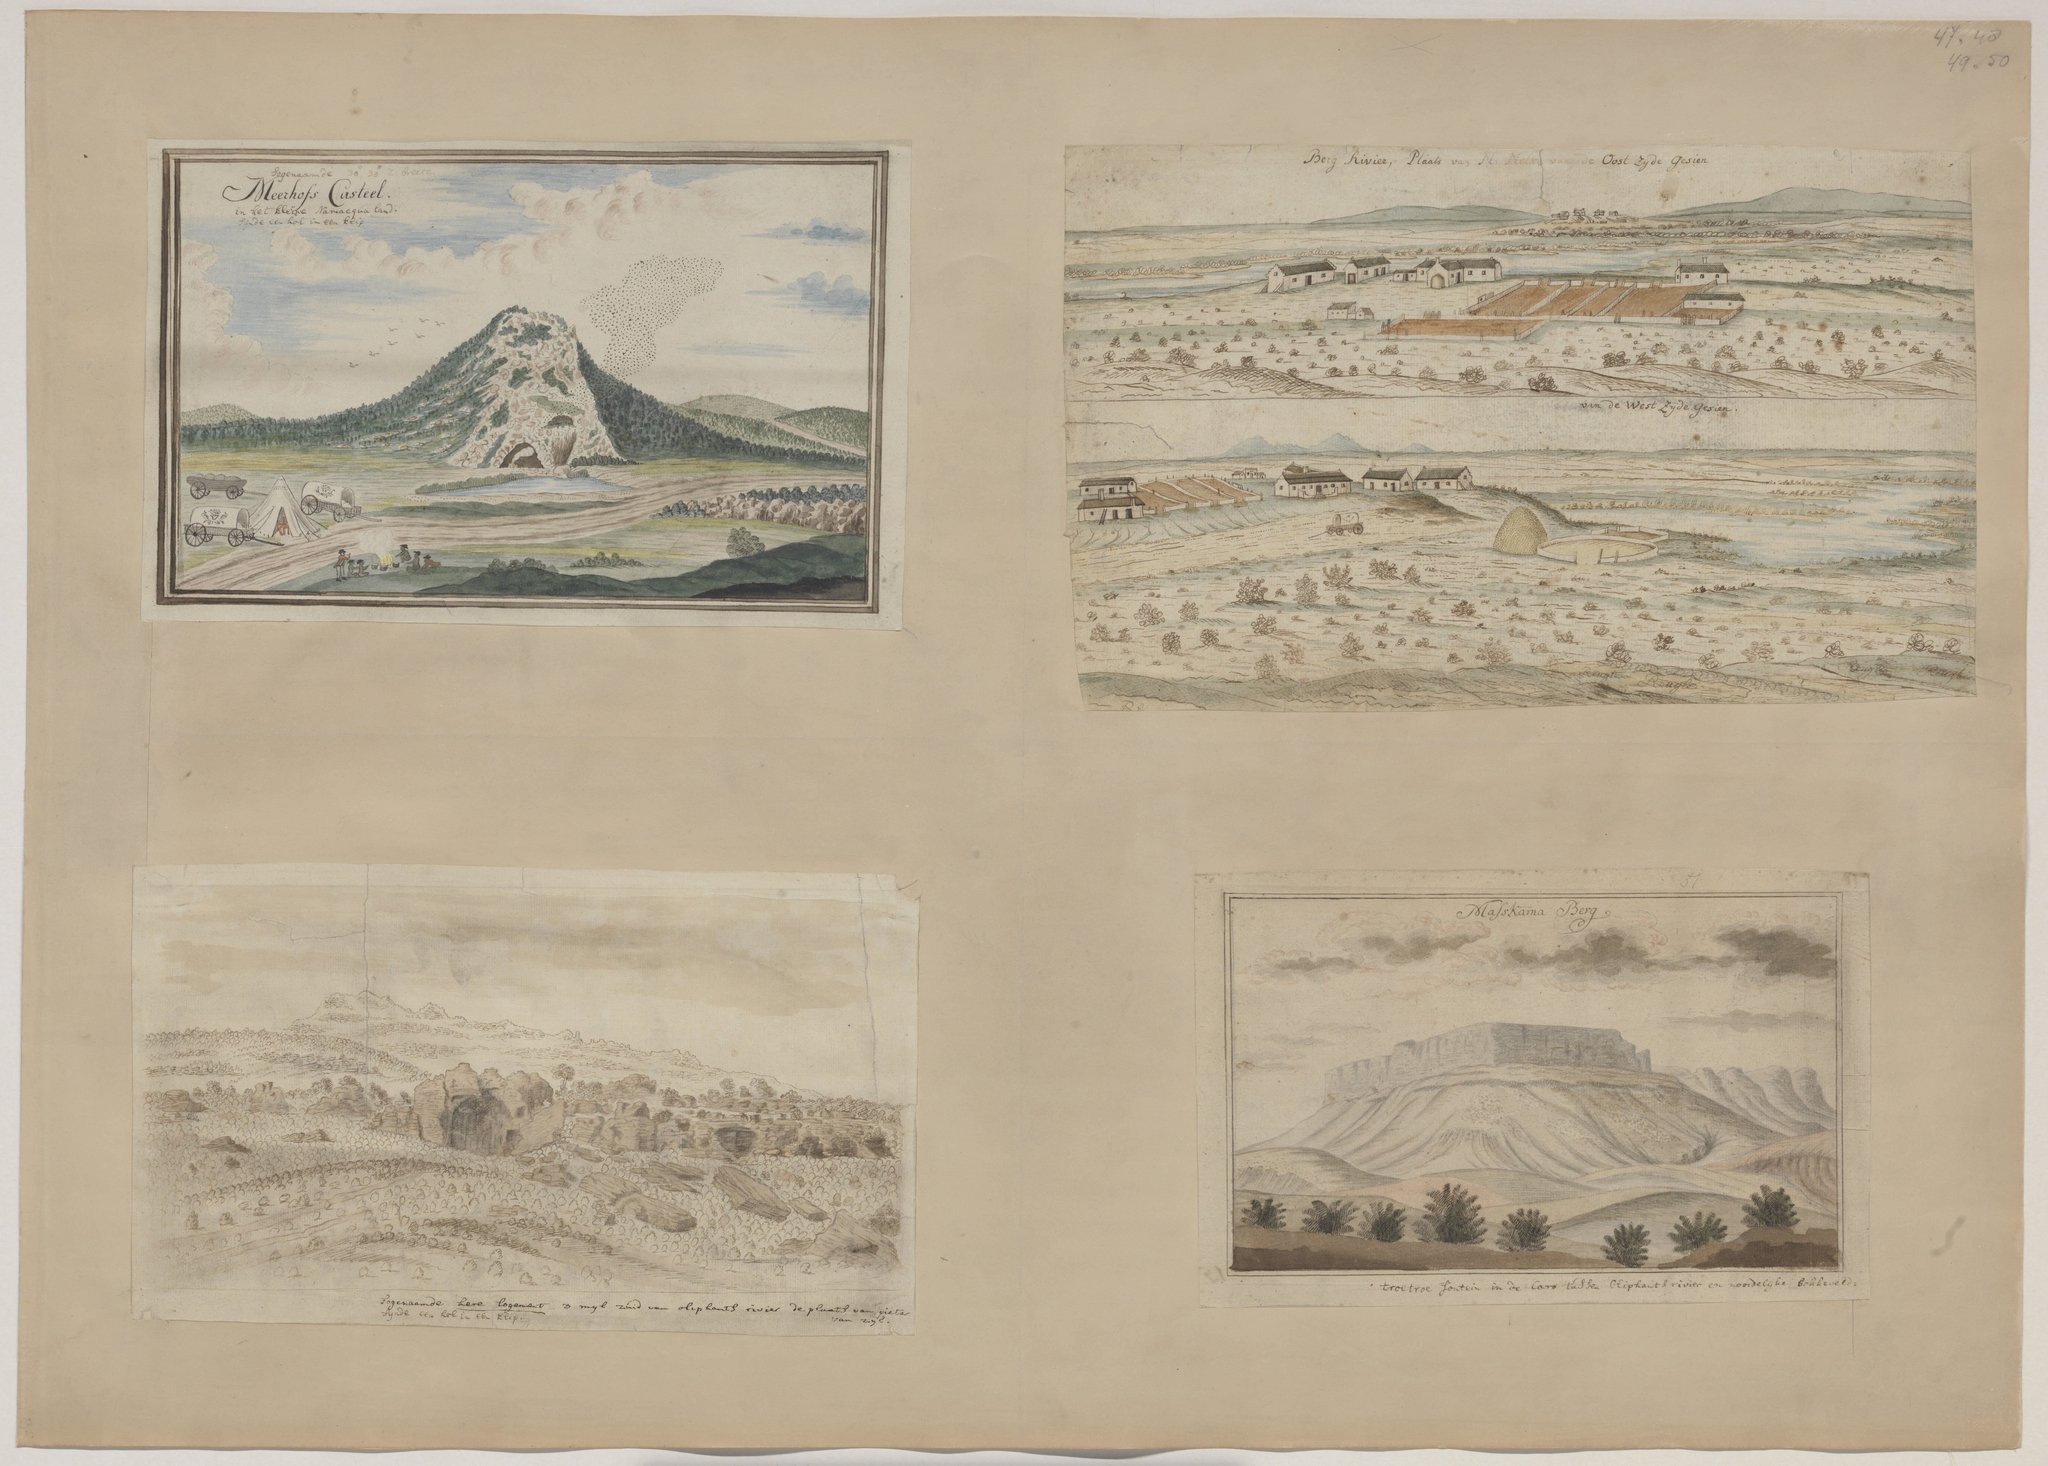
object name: drawing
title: The Massakama mountain and Troetroefontein, near the present village of Vanrhynsdorp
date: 1779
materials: ink, paper, pencil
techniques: brush, pen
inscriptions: annotation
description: Oorspronkelijk in omslag van roodkleurig halfleer en roodgemarmerd plat, dorso met ribben en goudopdruk; 71 x 99 x 6 cm.